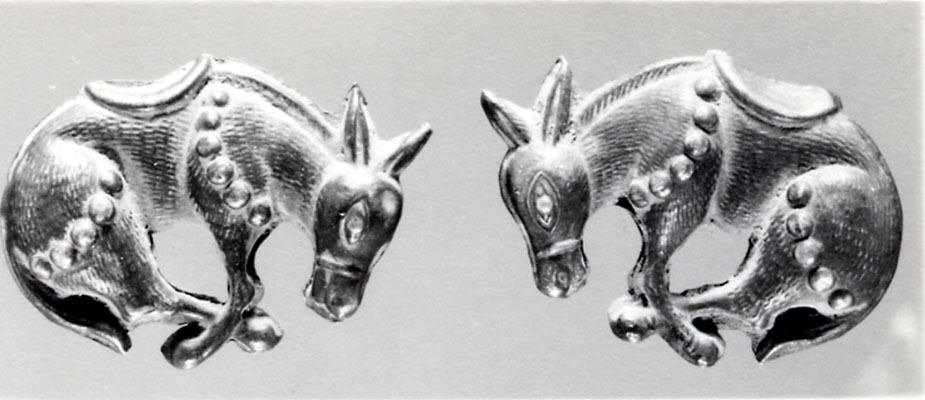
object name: rattle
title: Rattle?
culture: chinese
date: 220-589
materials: bronze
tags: musical instruments